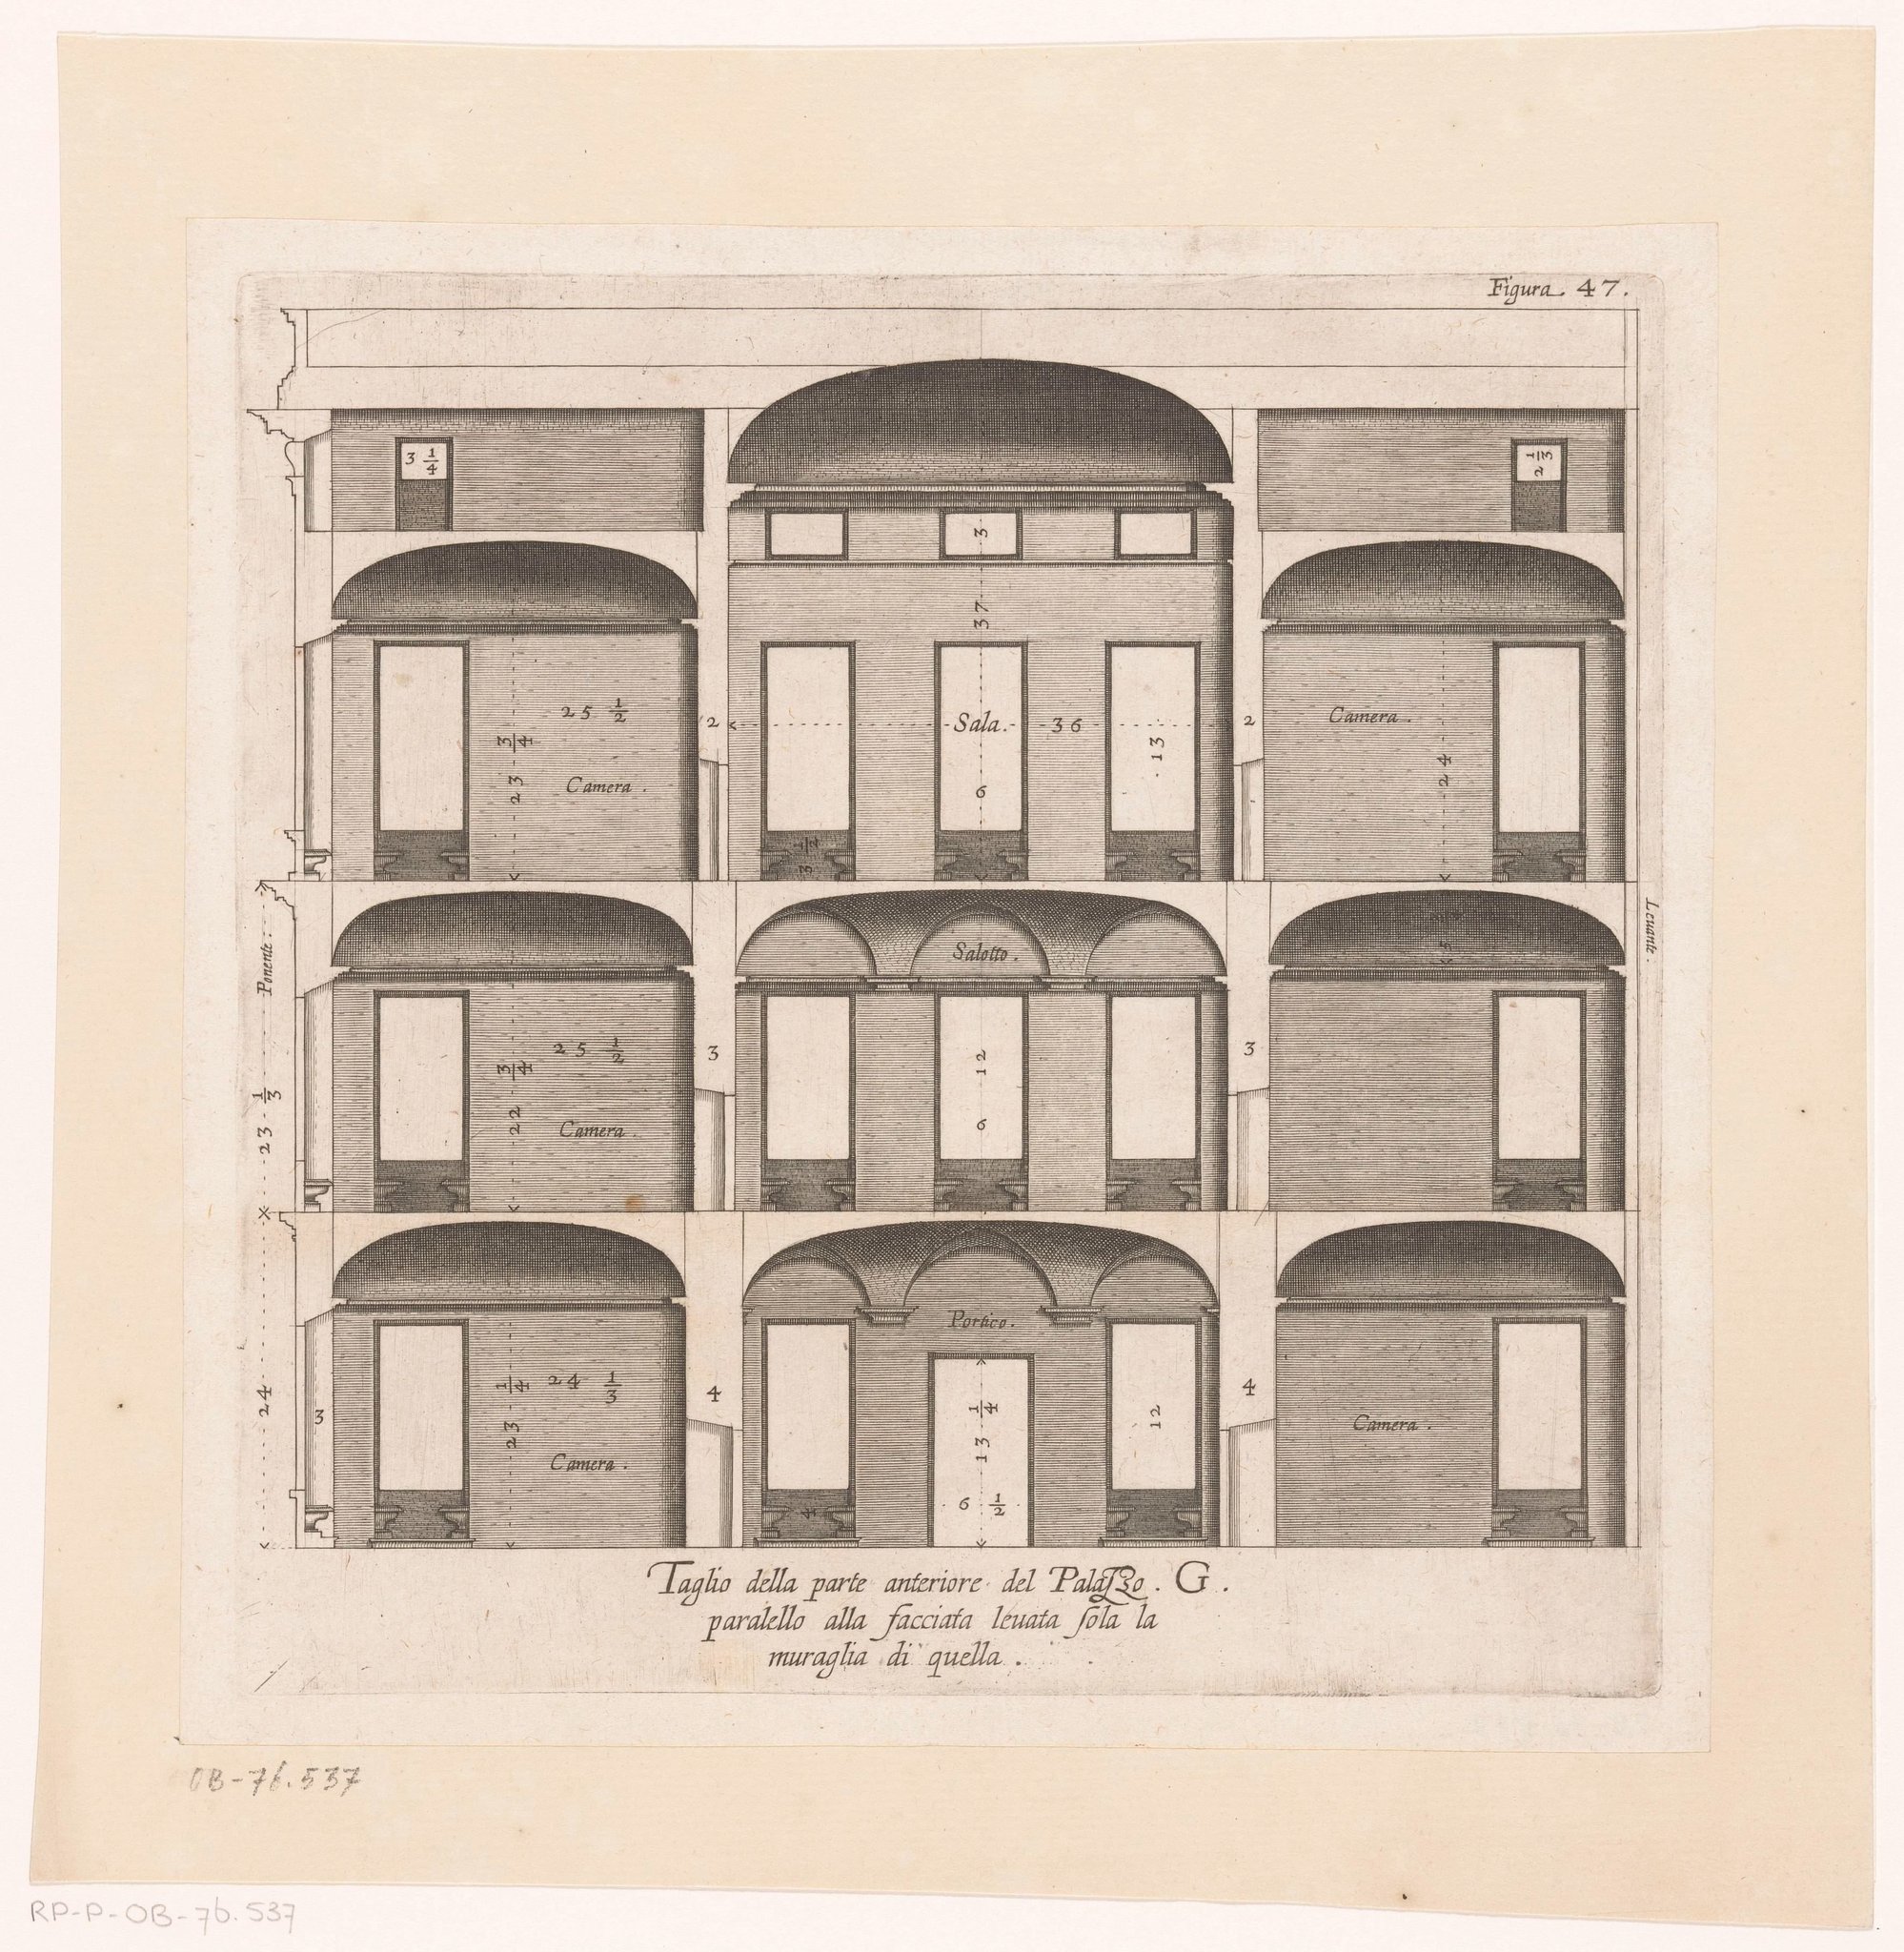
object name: ornament print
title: Palazzi di Genova / Palazzi Antichi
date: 1622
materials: paper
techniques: engraving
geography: antwerp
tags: hôtel, i.e. small palace in city - aa - civic architecture: inside, section ~ architectural design or model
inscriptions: collector's mark: Lugt 240